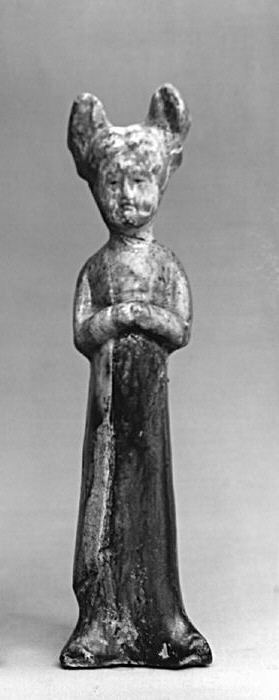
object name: figure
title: Figure of a standing woman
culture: chinese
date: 601-800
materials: glaze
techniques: polychrome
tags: women